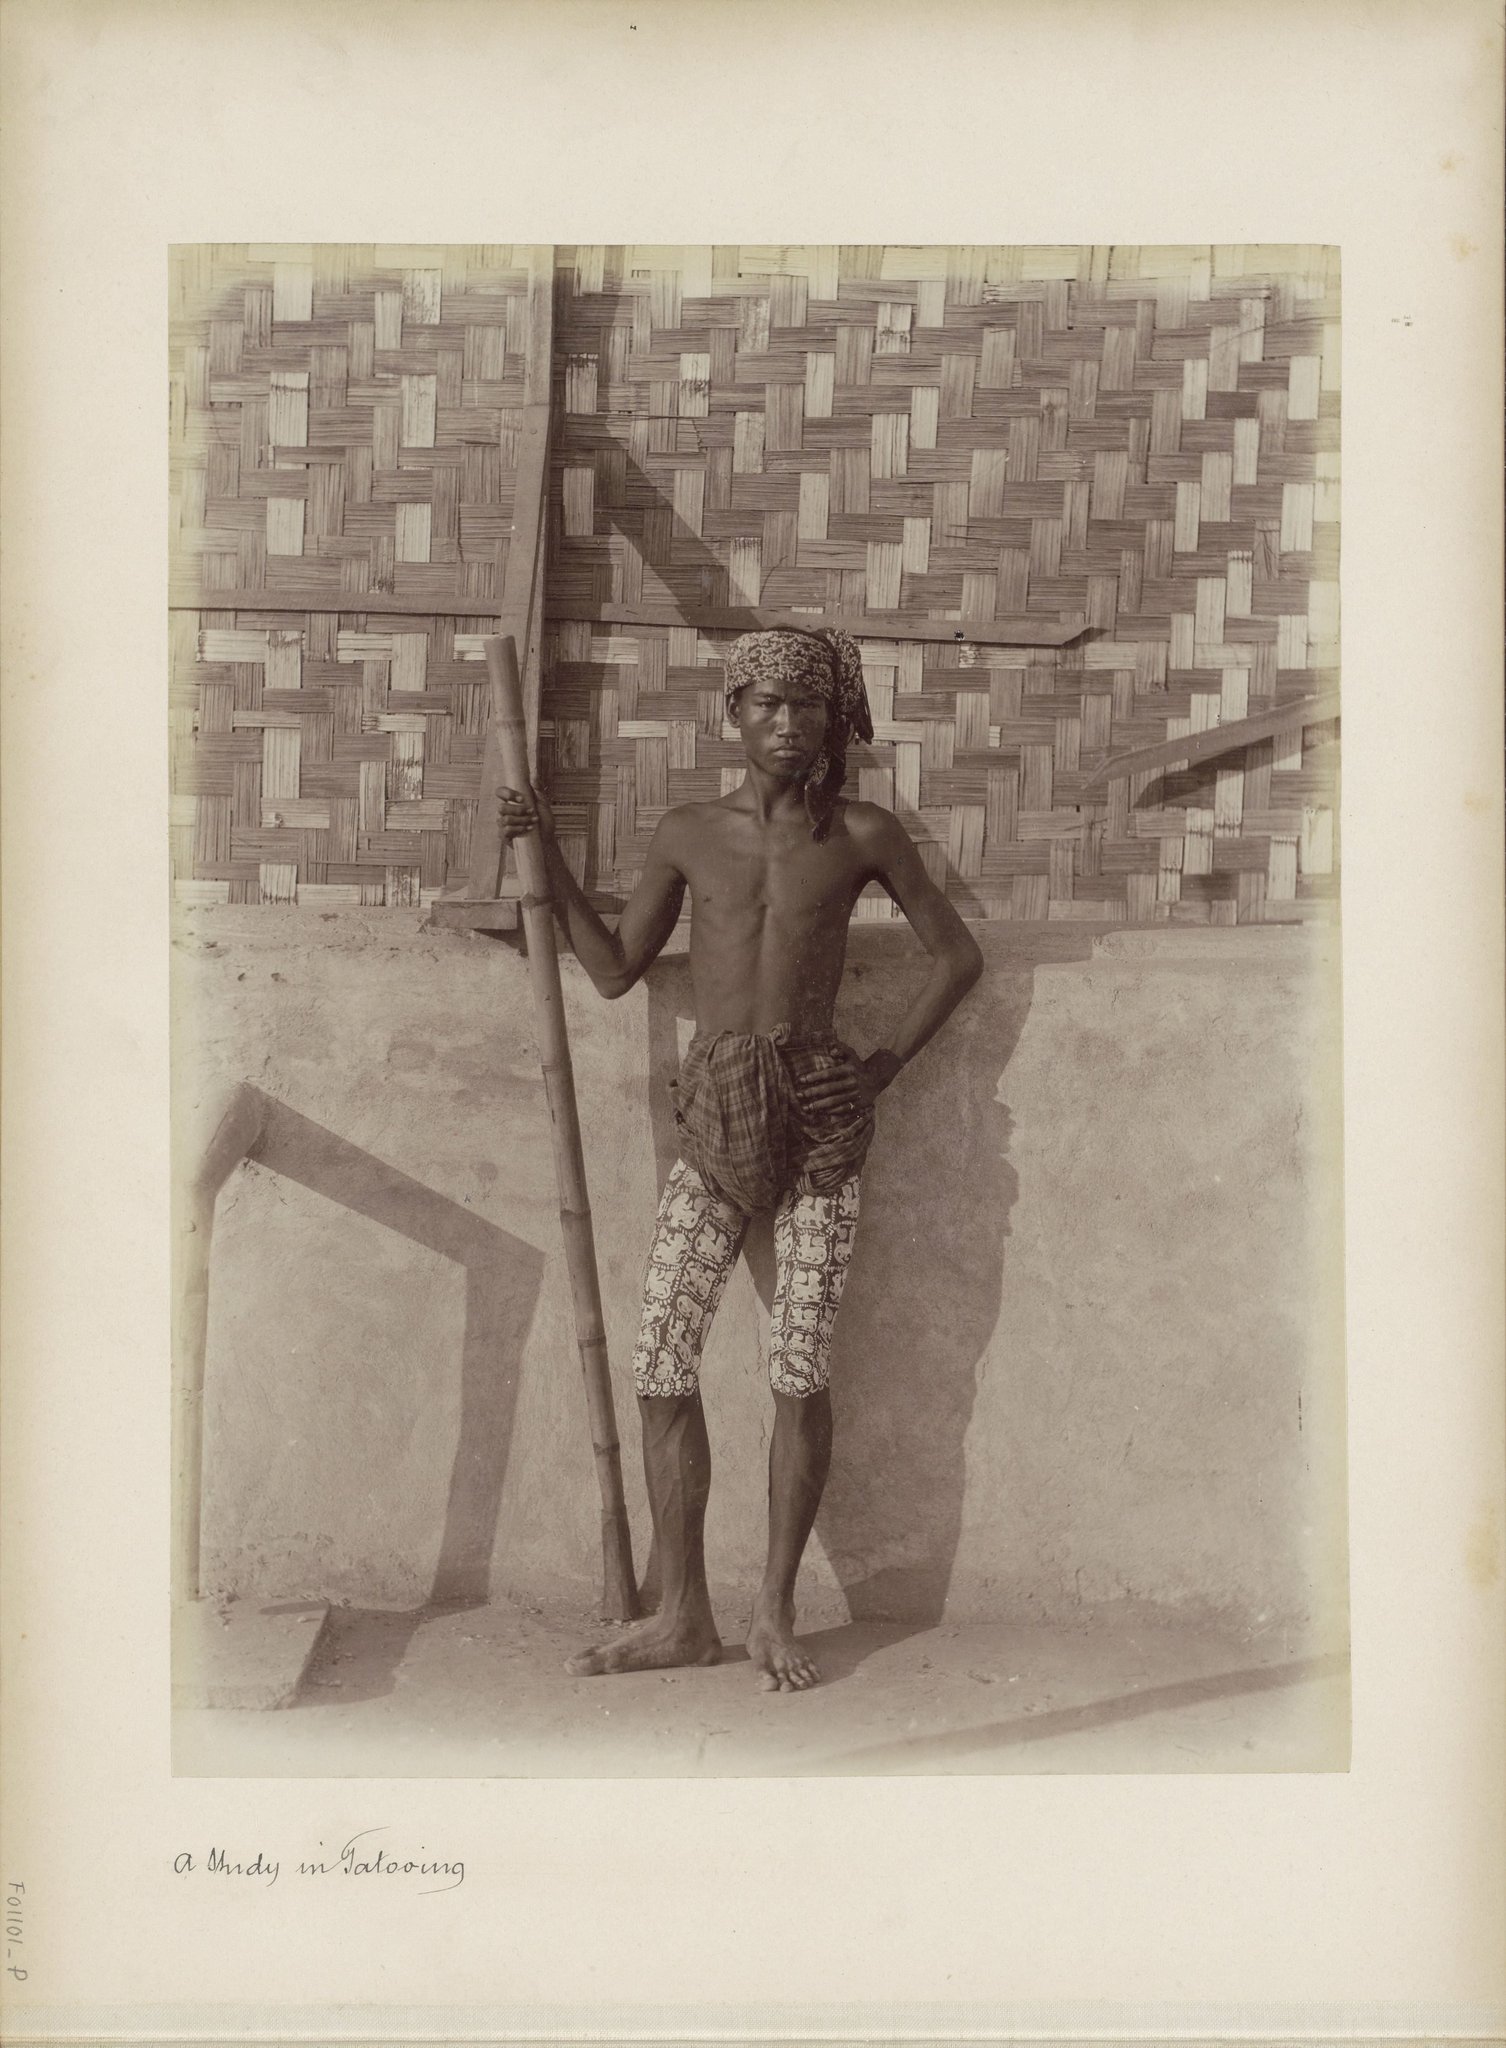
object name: album leaf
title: Portrait of a Burmese boy with tattooed or painted thighs, Myanmar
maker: Anonymous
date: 1885-1886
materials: cardboard, paper, photographic support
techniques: albumen print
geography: myanmar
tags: tattoo, youth, adolescent, painting of body or face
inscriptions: caption: ‘A Study in Tatooing’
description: Onderdeel van Reisalbum met foto's van bezienswaardigheden in Birma.